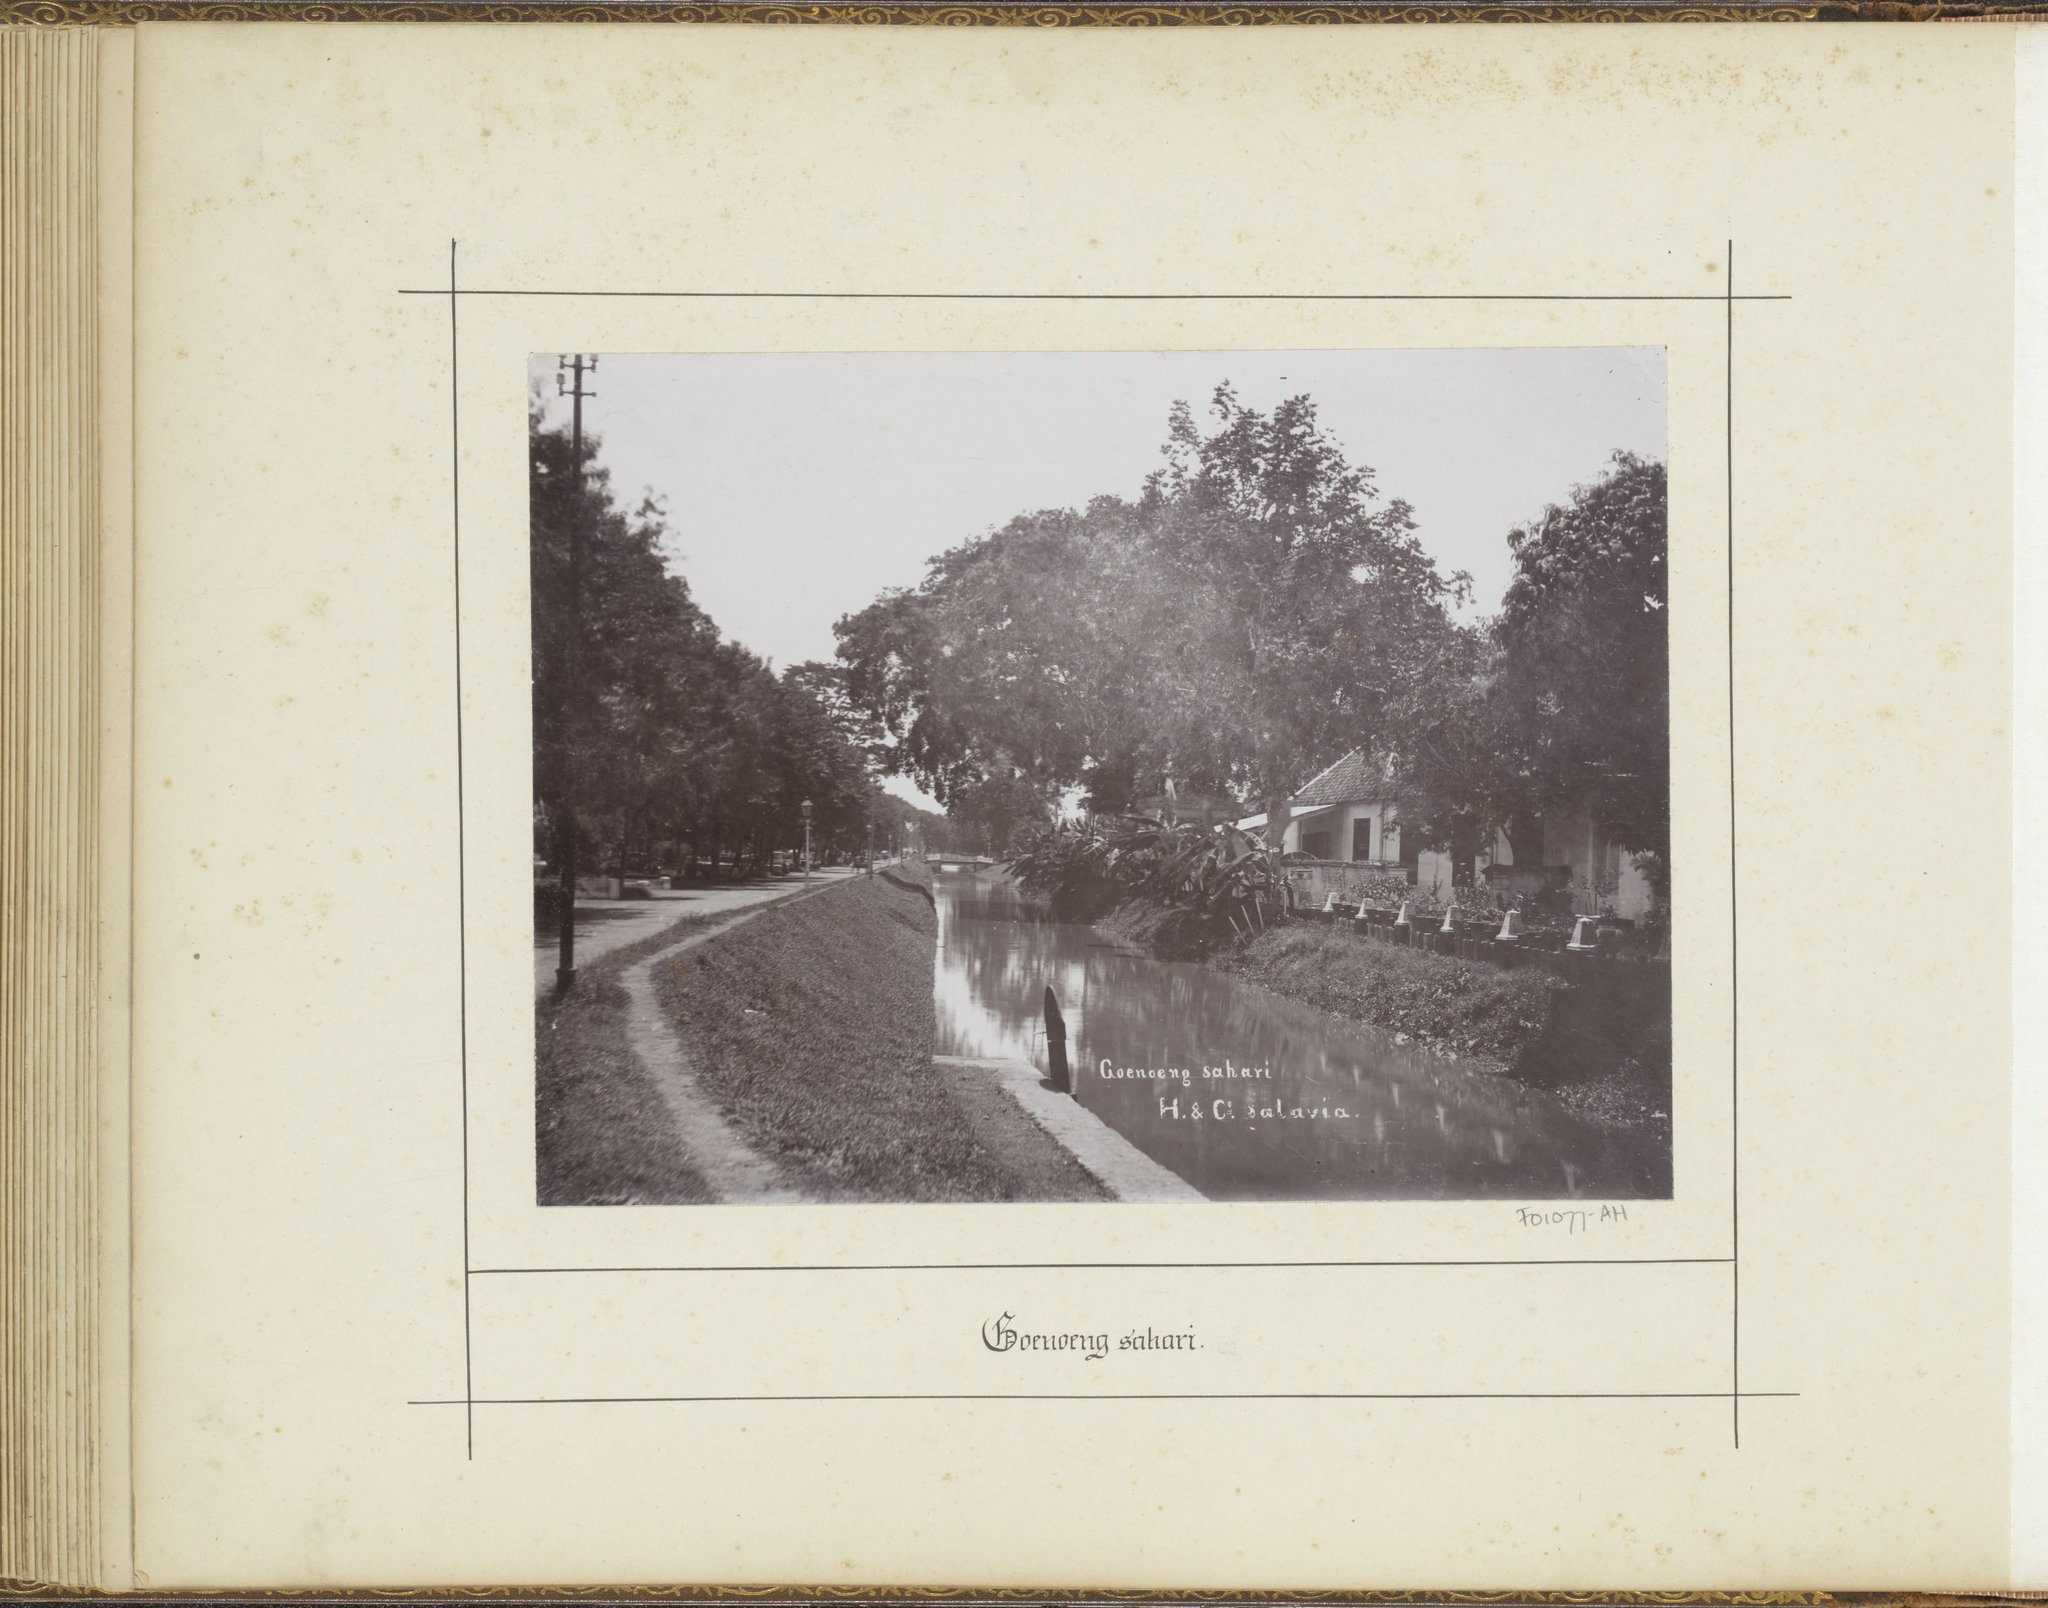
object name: photograph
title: Gezicht op een huis en het water van Gunung Sahari in Batavia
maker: otto hisgen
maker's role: fotograaf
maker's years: 1874-1944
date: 1890-1910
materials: cardboard, photographic support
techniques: collodion silver print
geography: batavia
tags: dikes, levee, canals, waters (in city), batavia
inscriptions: inscription: ‘Goenoen sahari’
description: Onderdeel van Album met foto's van Batavia en van de zusters Ursulinen.